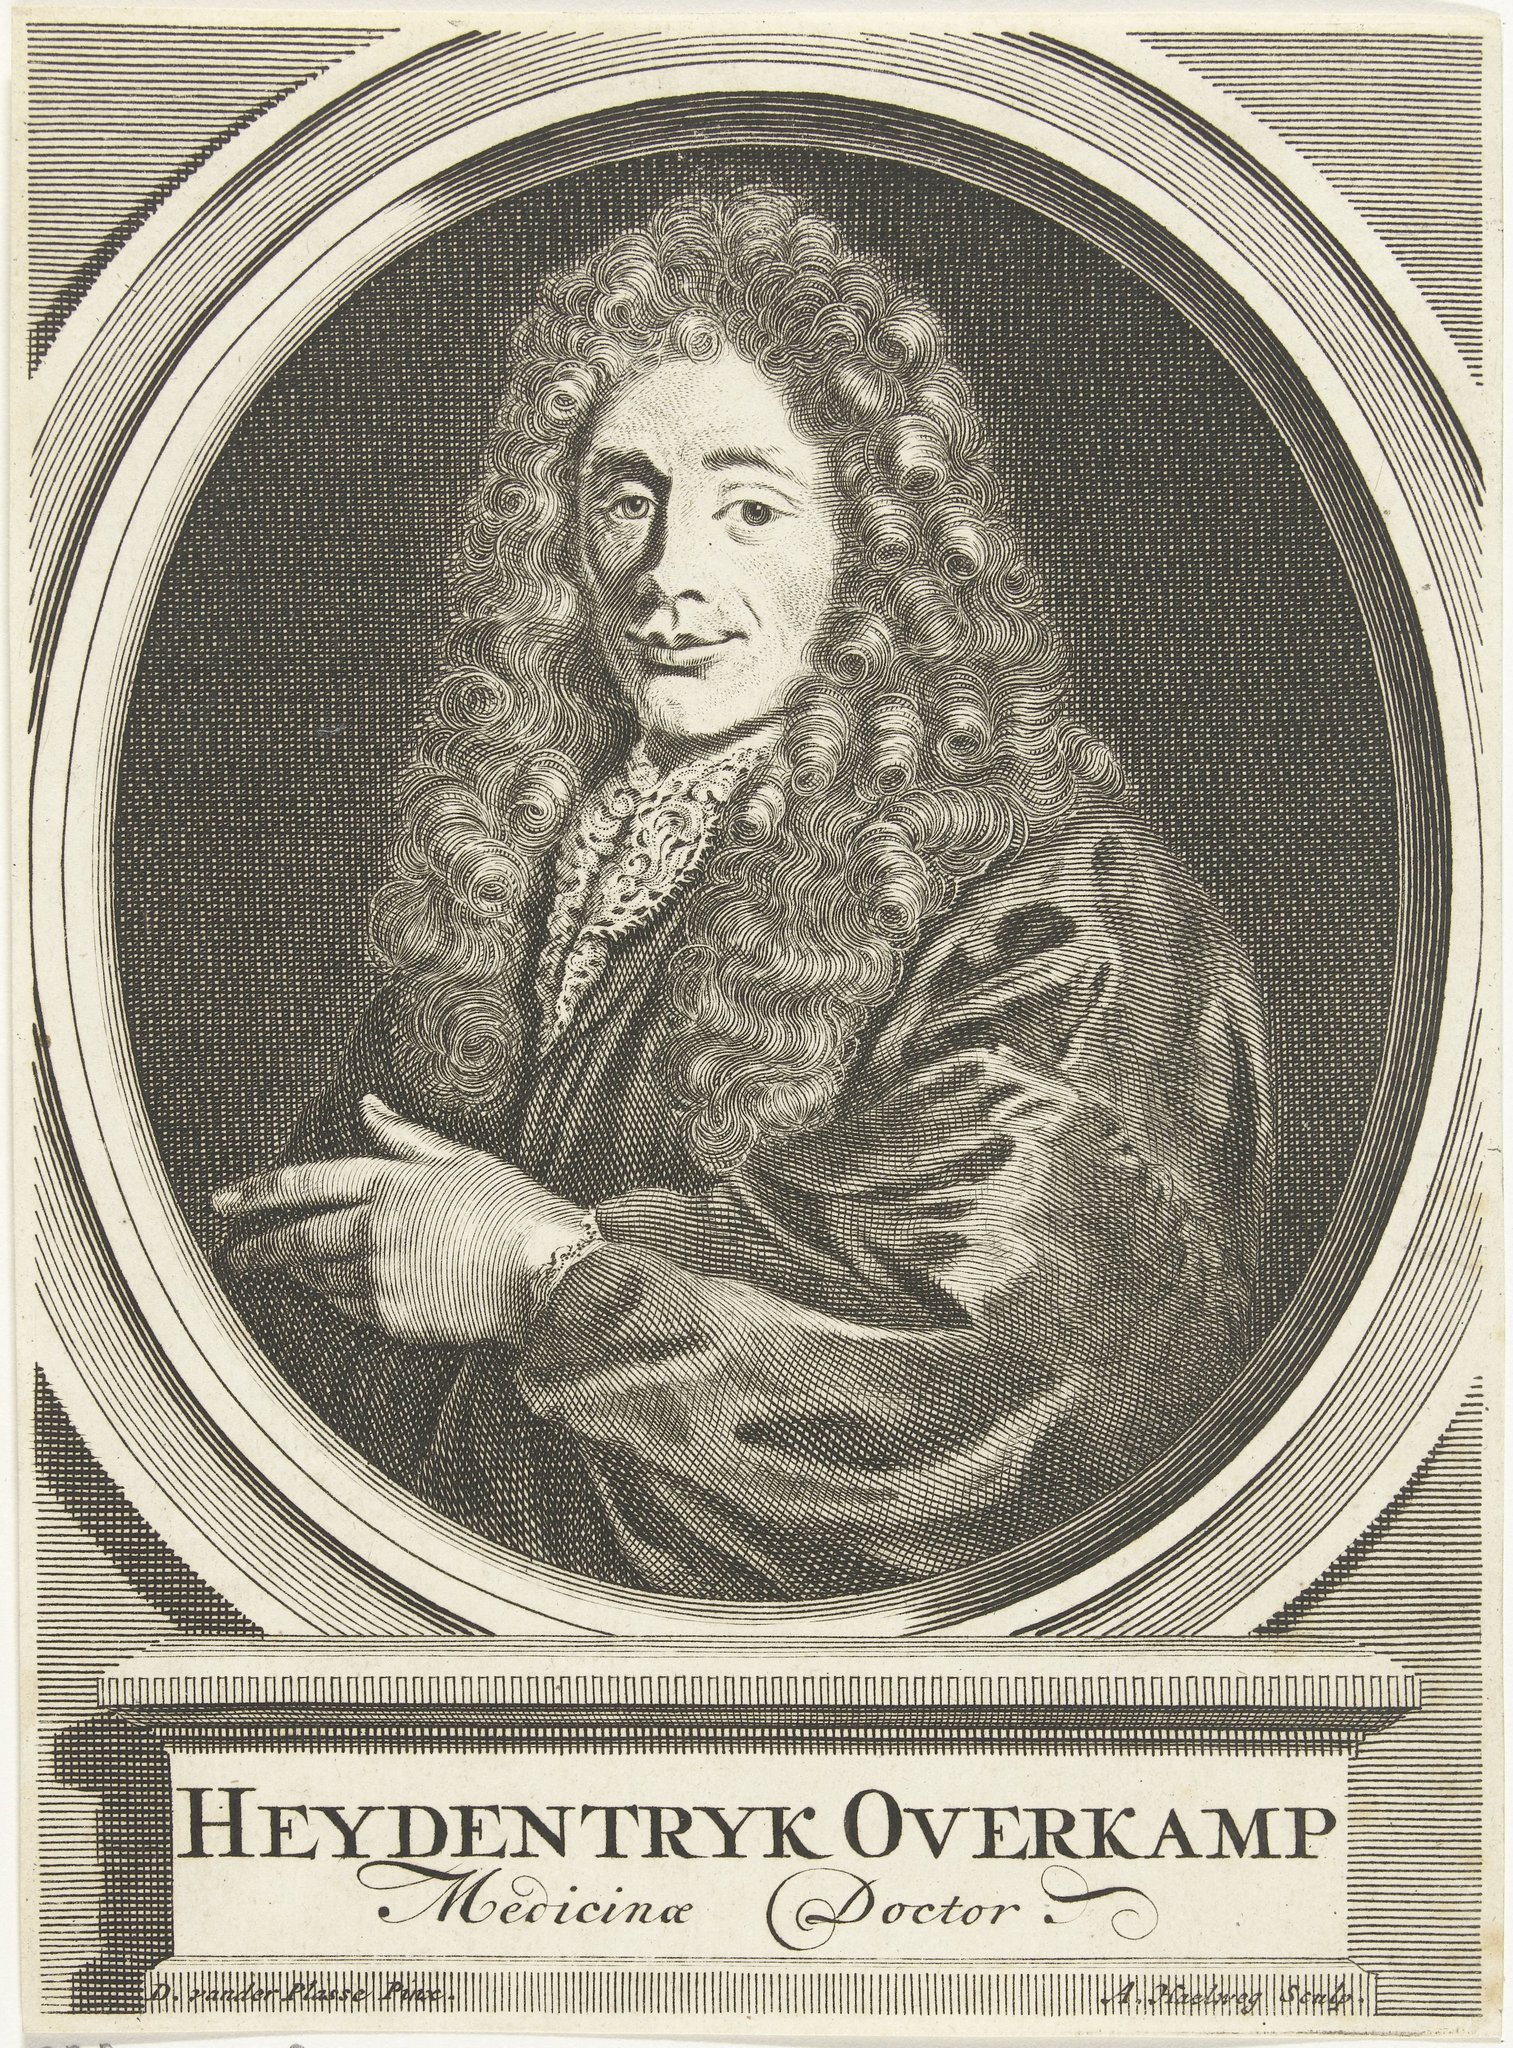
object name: print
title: Portret van Heydentrijk Overkamp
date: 1667-1696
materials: paper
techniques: engraving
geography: northern netherlands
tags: amsterdam, styles of hairdress, lace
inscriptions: collector's mark: Lugt 2228